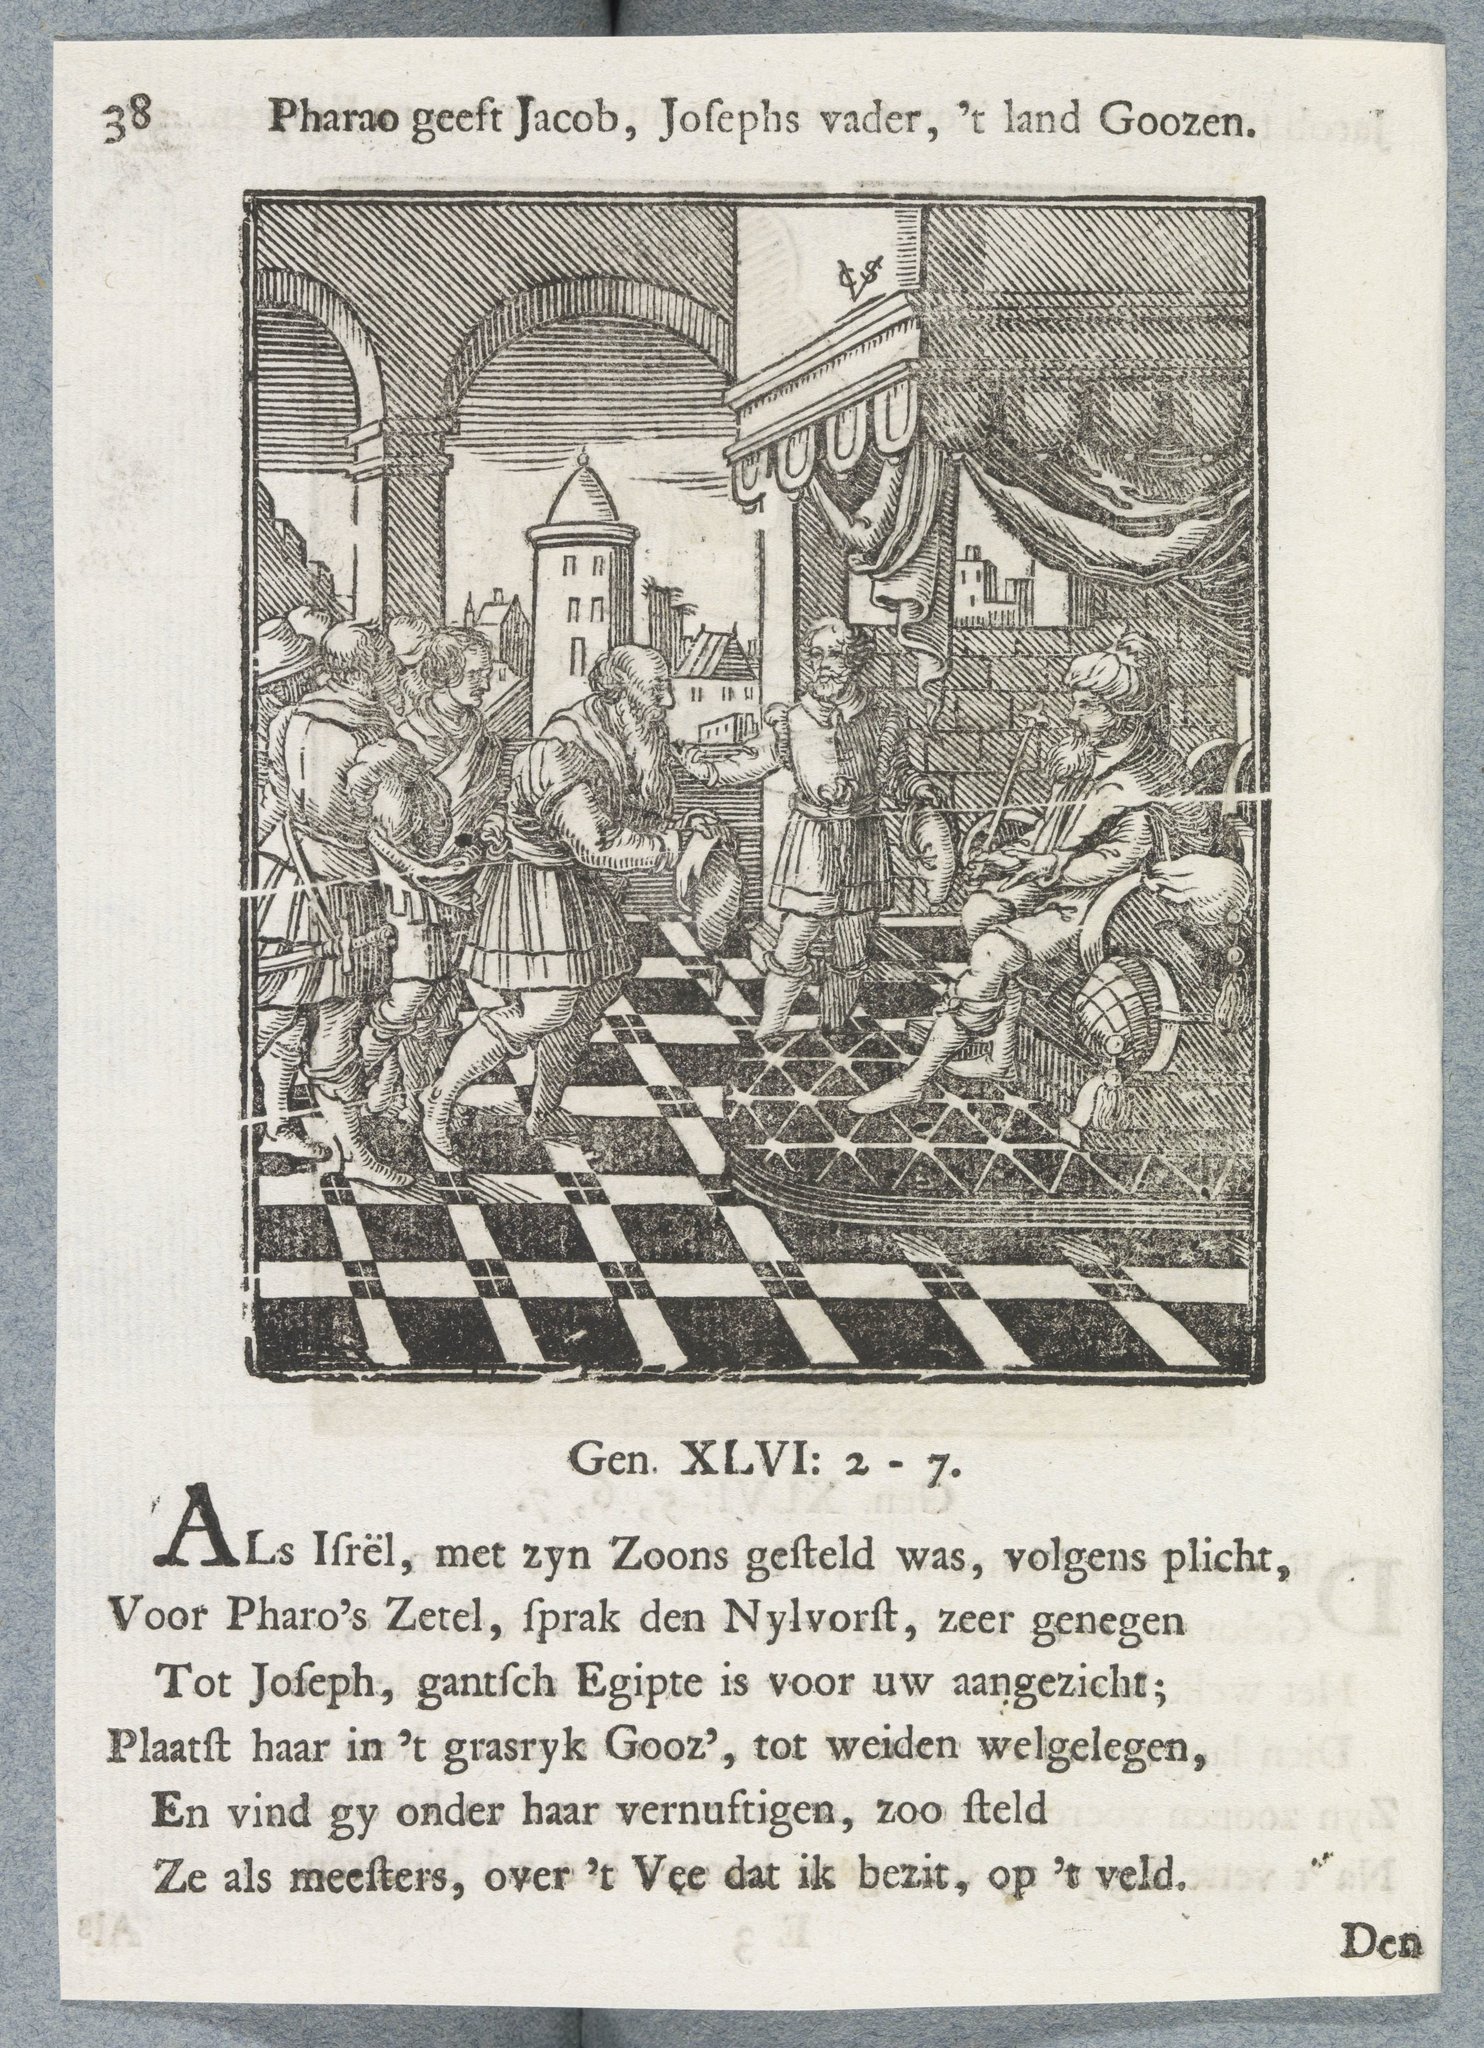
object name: album leaf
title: Pharao geeft Jacob, Josephs vader, 't land Goozen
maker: jan klooster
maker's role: bookseller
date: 1645-1646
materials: paper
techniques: letterpress printing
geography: amsterdam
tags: jacob is presented to pharaoh by joseph, joseph and five of his brothers tell pharaoh of jacob's arrival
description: Jakob stelt zijn vader Joseph voor aan de farao, zittend op een troon onder een baldakijn. Links vijf van Jakobs broers. De farao geeft toestemming om in Gosen te gaan wonen. Boven de voorstelling een titel. Eronder zes versregels en een verwijzing naar Genesis 46: 2-7 (bedoeld wordt Genesis 47: 2-7). De prent maakt deel uit van een album.